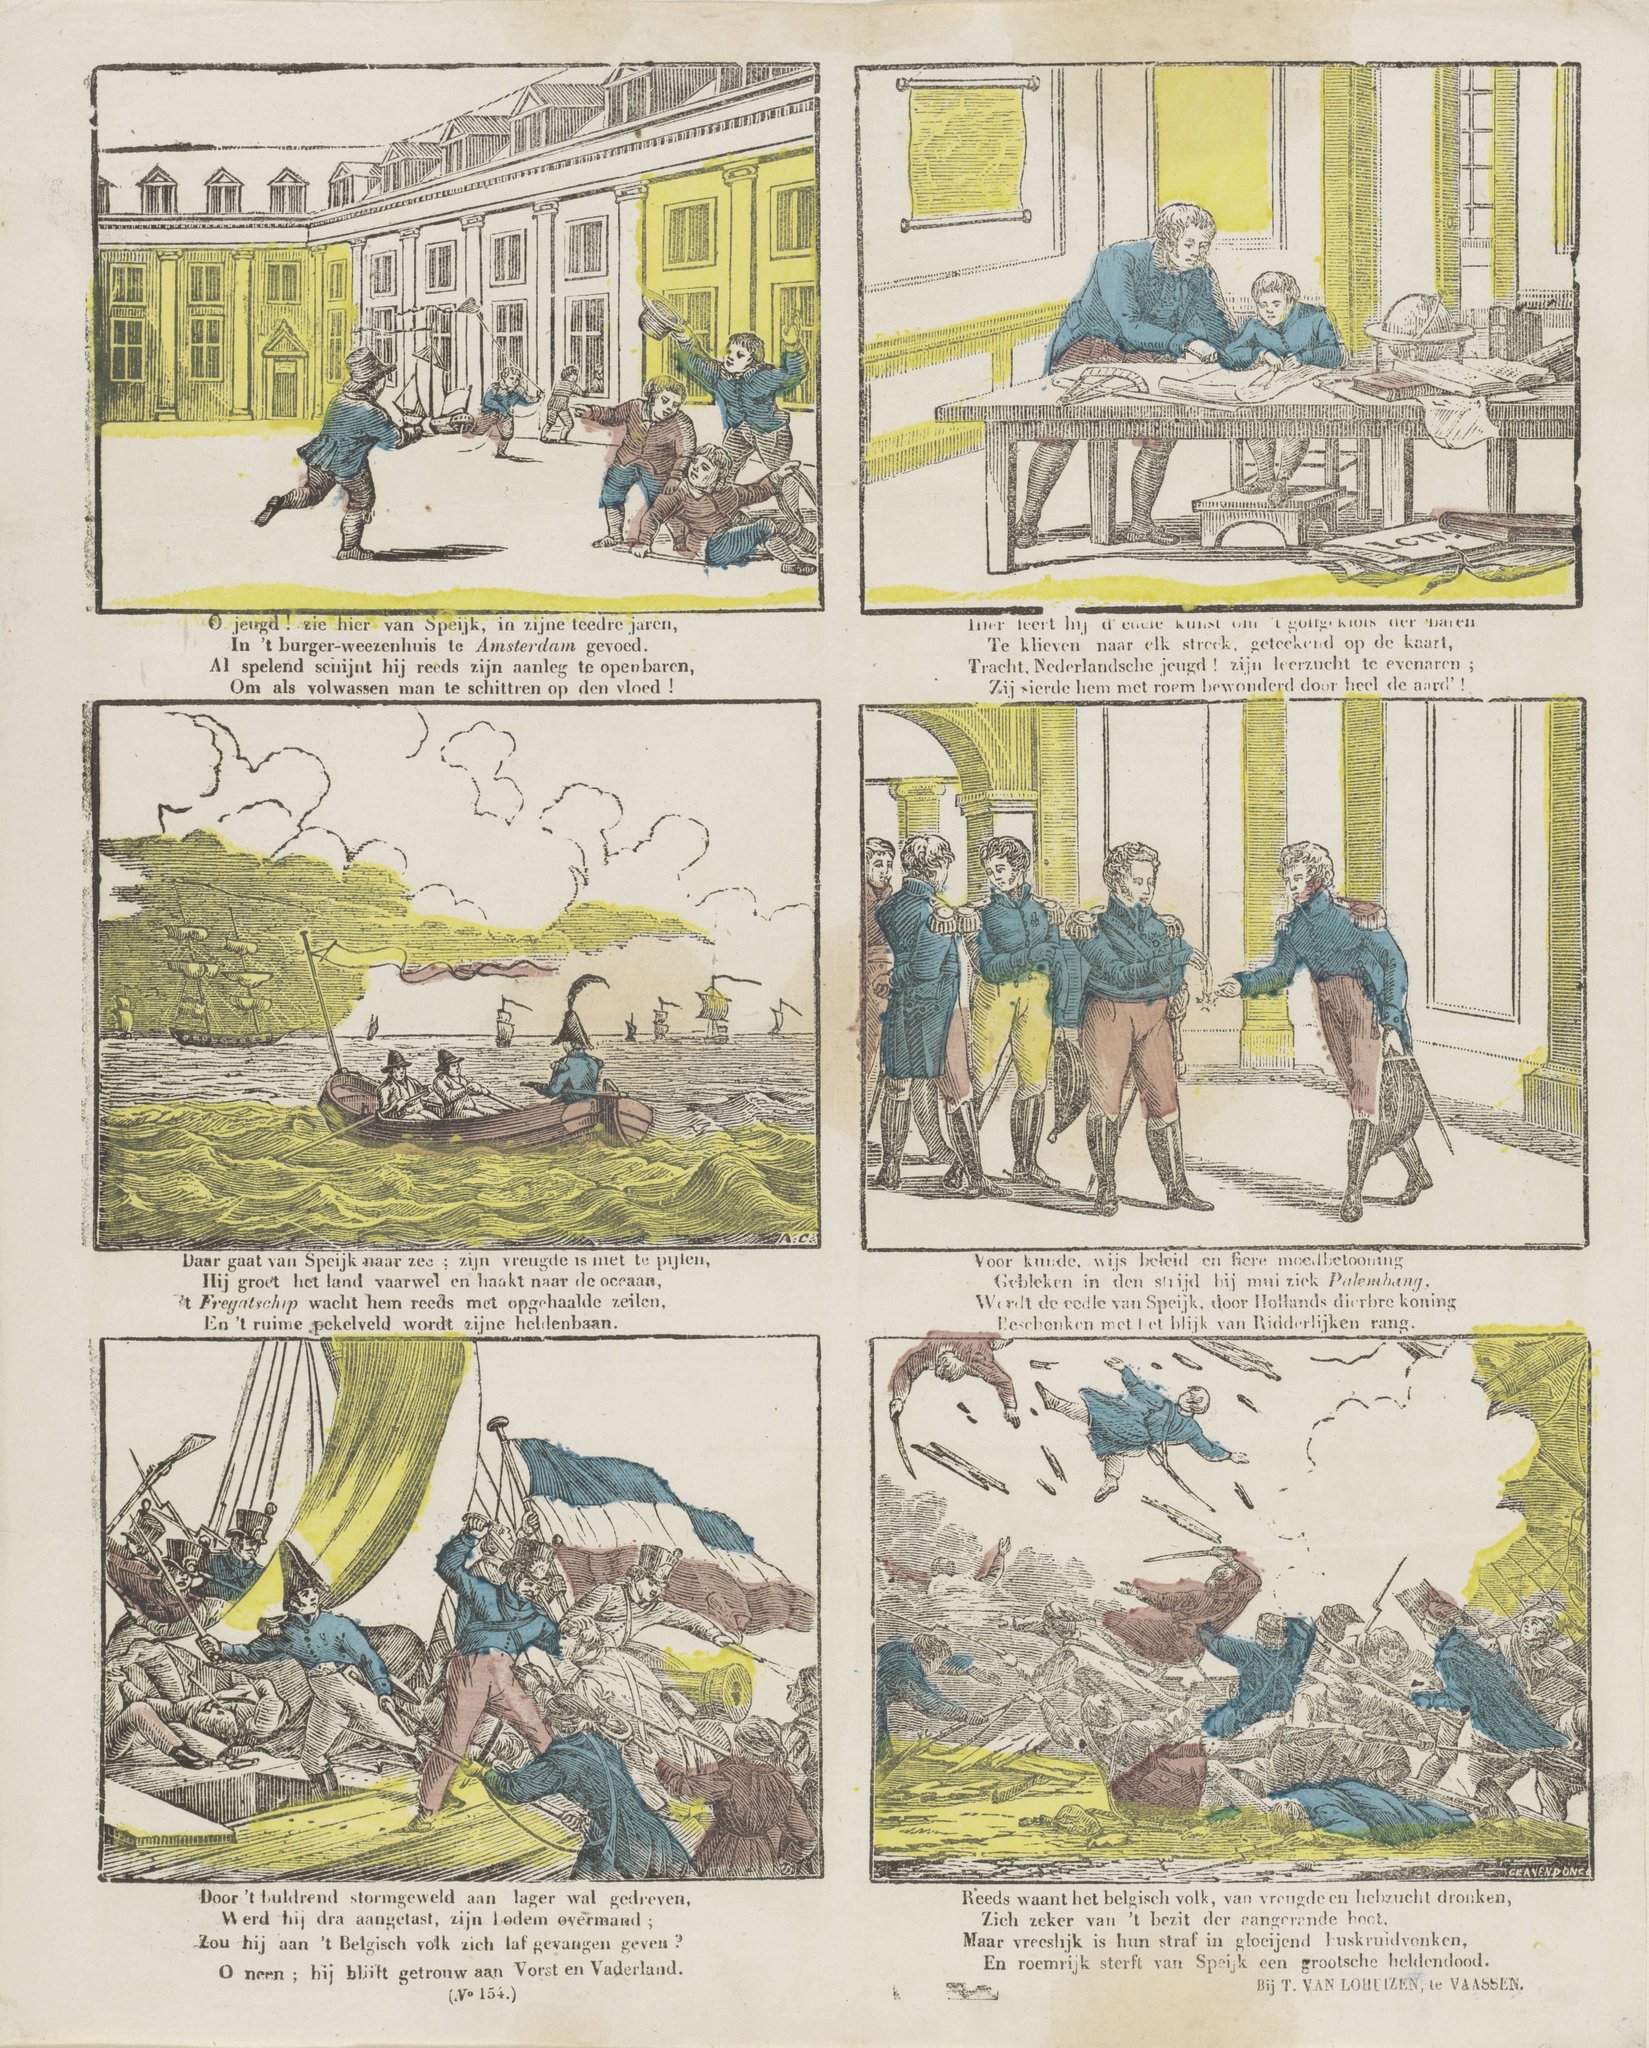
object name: print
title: Leven van J.C.J. van Speyk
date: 1831-1899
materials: paper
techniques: colour, letterpress printing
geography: netherlands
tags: amsterdam, antwerp, jan van speyk, battle, revolution, revolt, orphans, netherlands, belgium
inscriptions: collector's mark: Lugt 2228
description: Blad met 6 voorstellingen over het leven en de zelfopoffering van J.C.J. van Speyk tijdens de strijd tegen de Belgen. Onder elke afbeelding een vierregelig vers. Genummerd linksonder: (No 154).